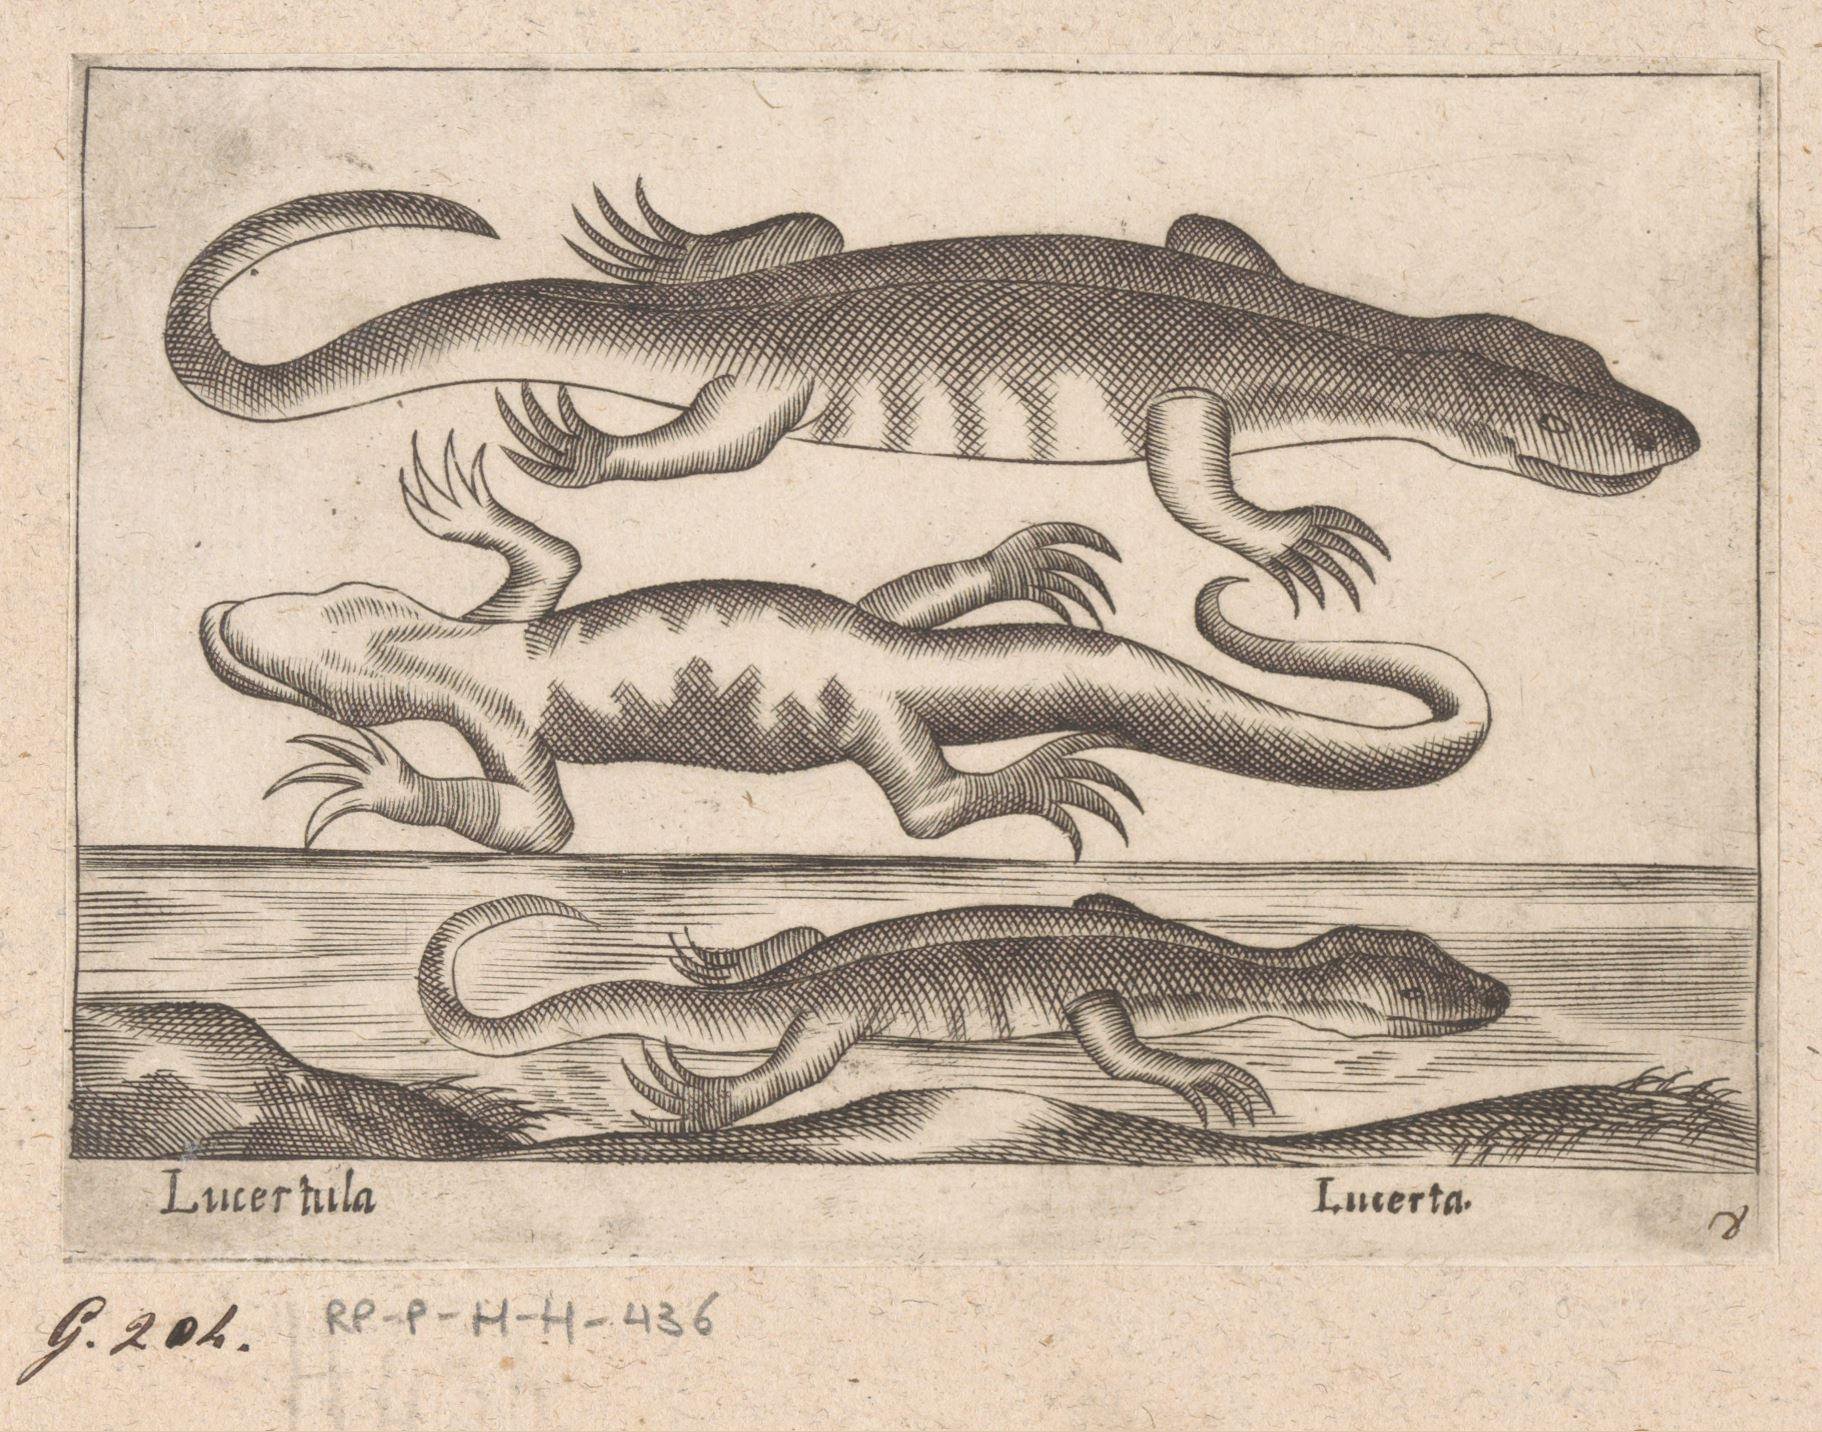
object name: print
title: Lucertula/ Lucerta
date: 1565-1630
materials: paper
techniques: etching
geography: rome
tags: lizards, lizards: lizard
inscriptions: number: ‘8’, collector's mark: Lugt 11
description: Deze prent maakt deel uit van een reeks prenten van dieren door Antonio Tempesta. Bekend is dat een tweede staat (met nummering) van deze serie is uitgegeven door Giovanni Giacomo de' Rossi in 1650. Onbekend is wie de eerste staat heeft uitgegeven en wanneer.